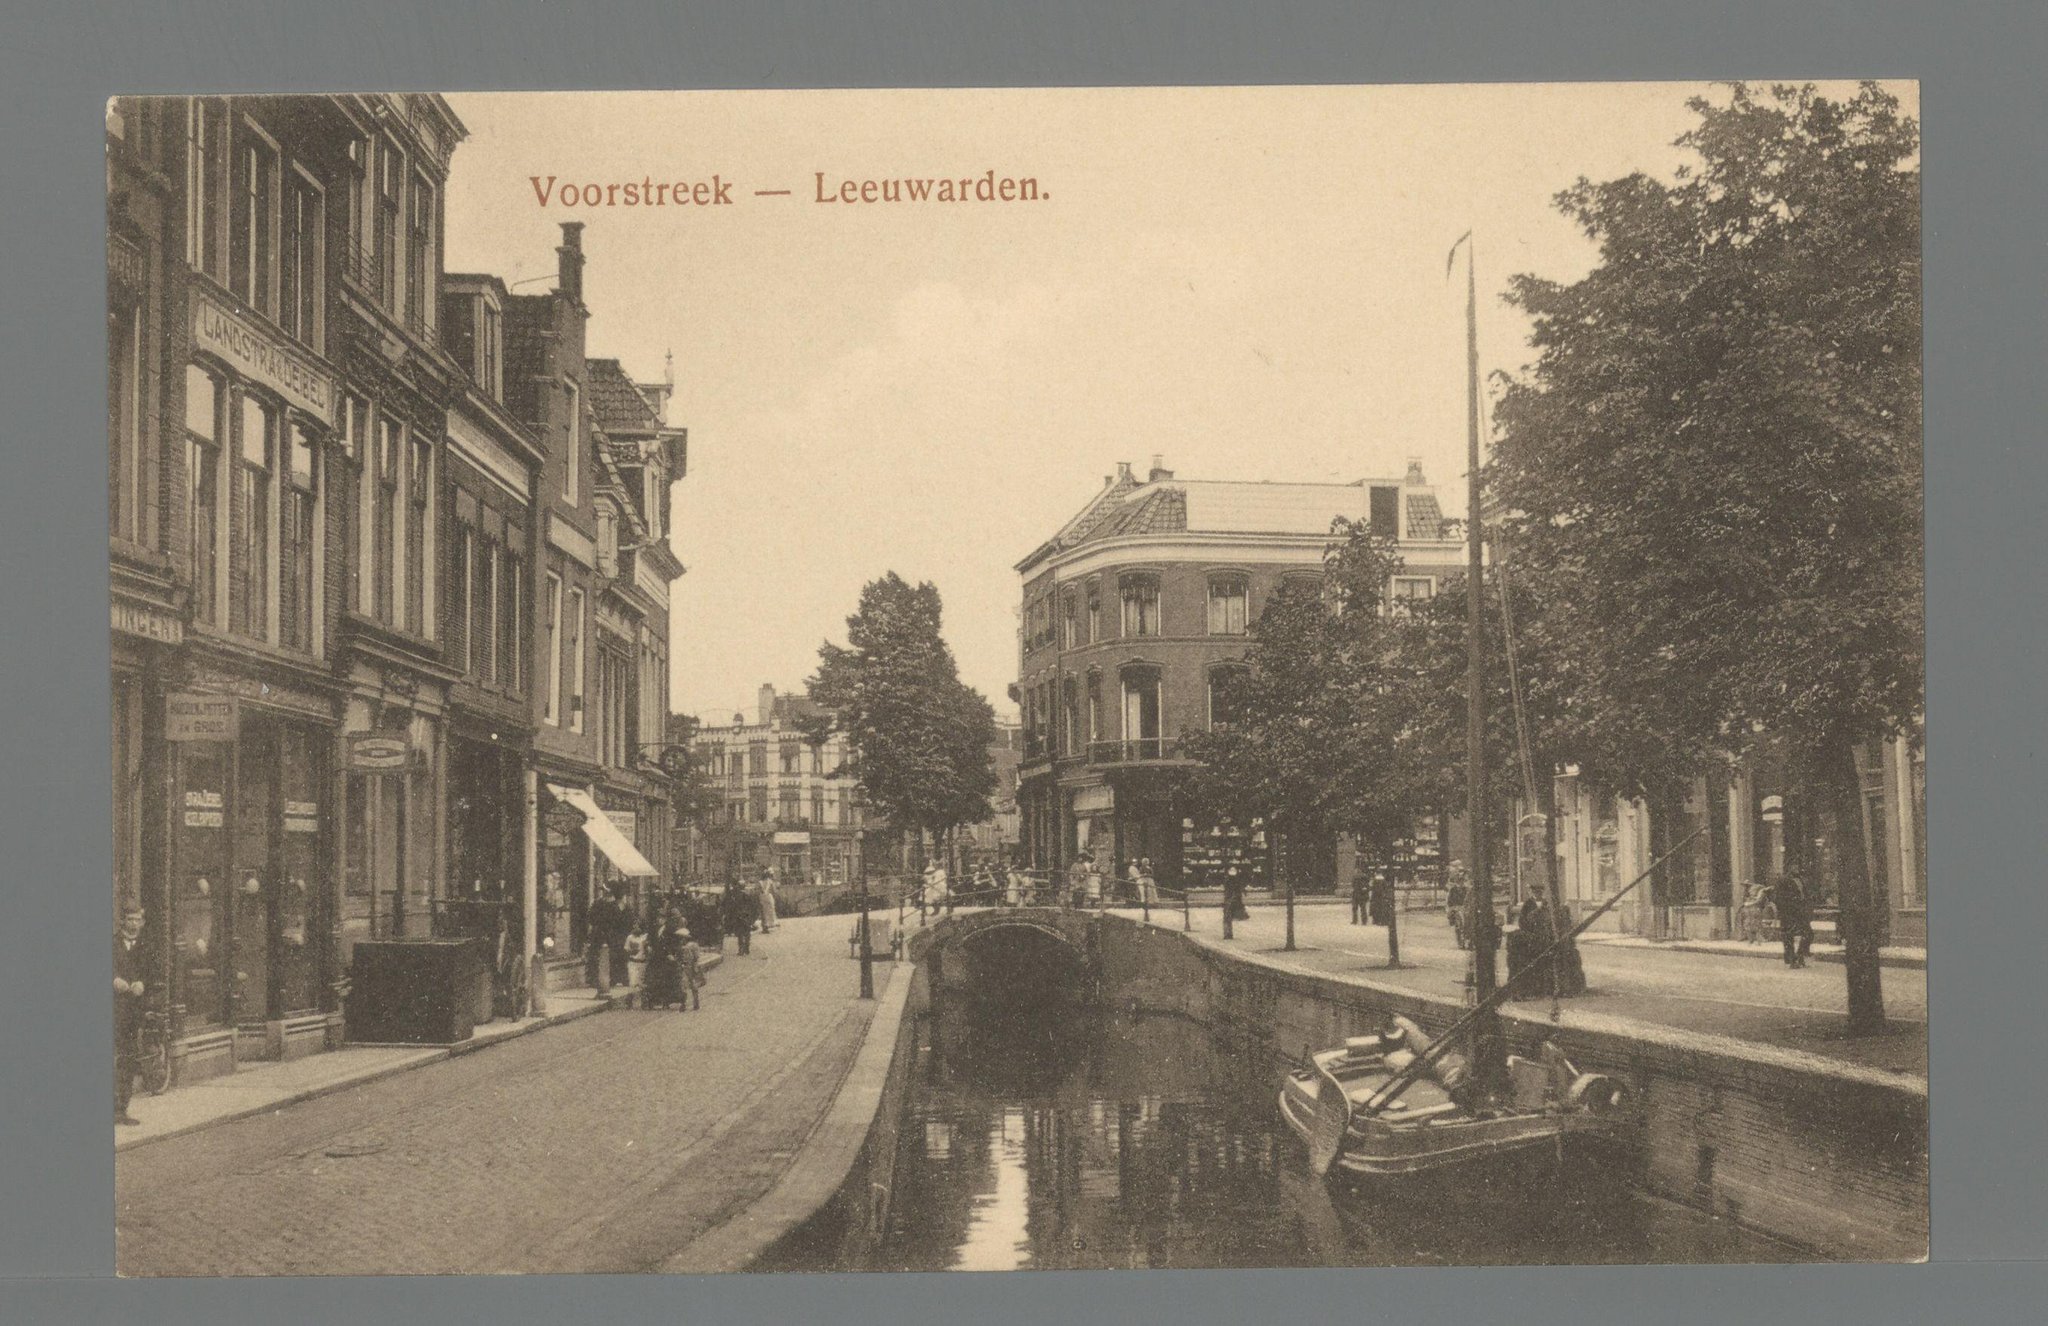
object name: ansichtkaart, prentbriefkaart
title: Voorstreek - Leeuwarden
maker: Anonymous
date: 1905-1930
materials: cardboard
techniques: photograph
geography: zwolle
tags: sailing-ship, sailing-boat, canal, street